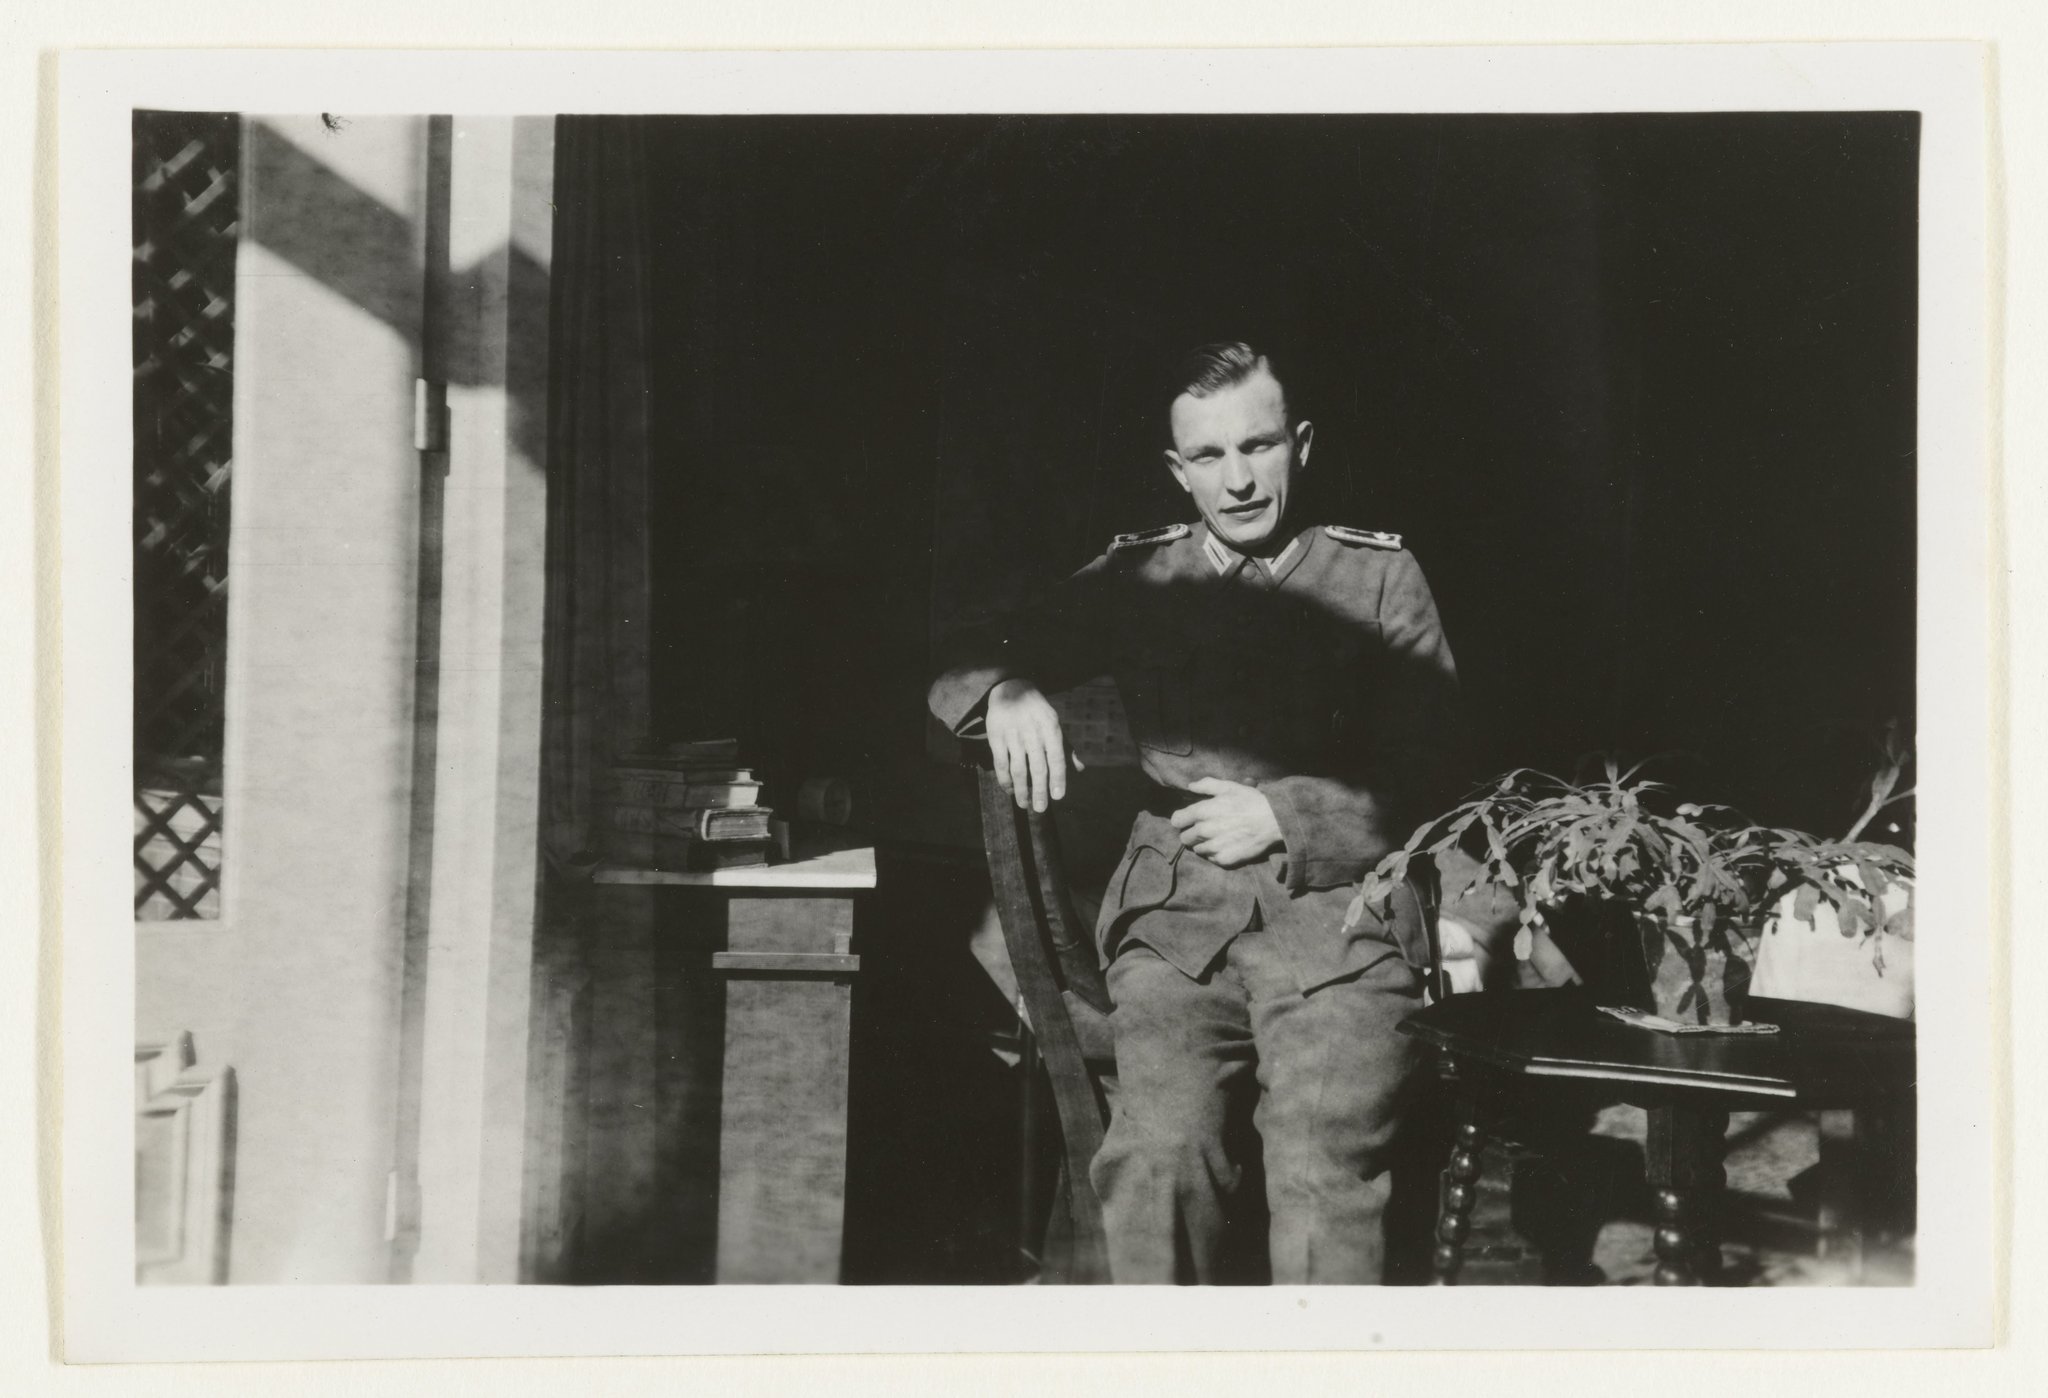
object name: photograph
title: Wehrmacht militair zit in de zon.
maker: Anonymous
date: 1941-1942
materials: photographic support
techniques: gelatin silver print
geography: netherlands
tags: recreation ~ the soldier off duty, occupation ~ war, netherlands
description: Een Wehrmacht militair zit op een stoel voor een open deur in de zon. Rechts van hem een plant en links een kastje met boeken er op. Hij is blootshoofd.